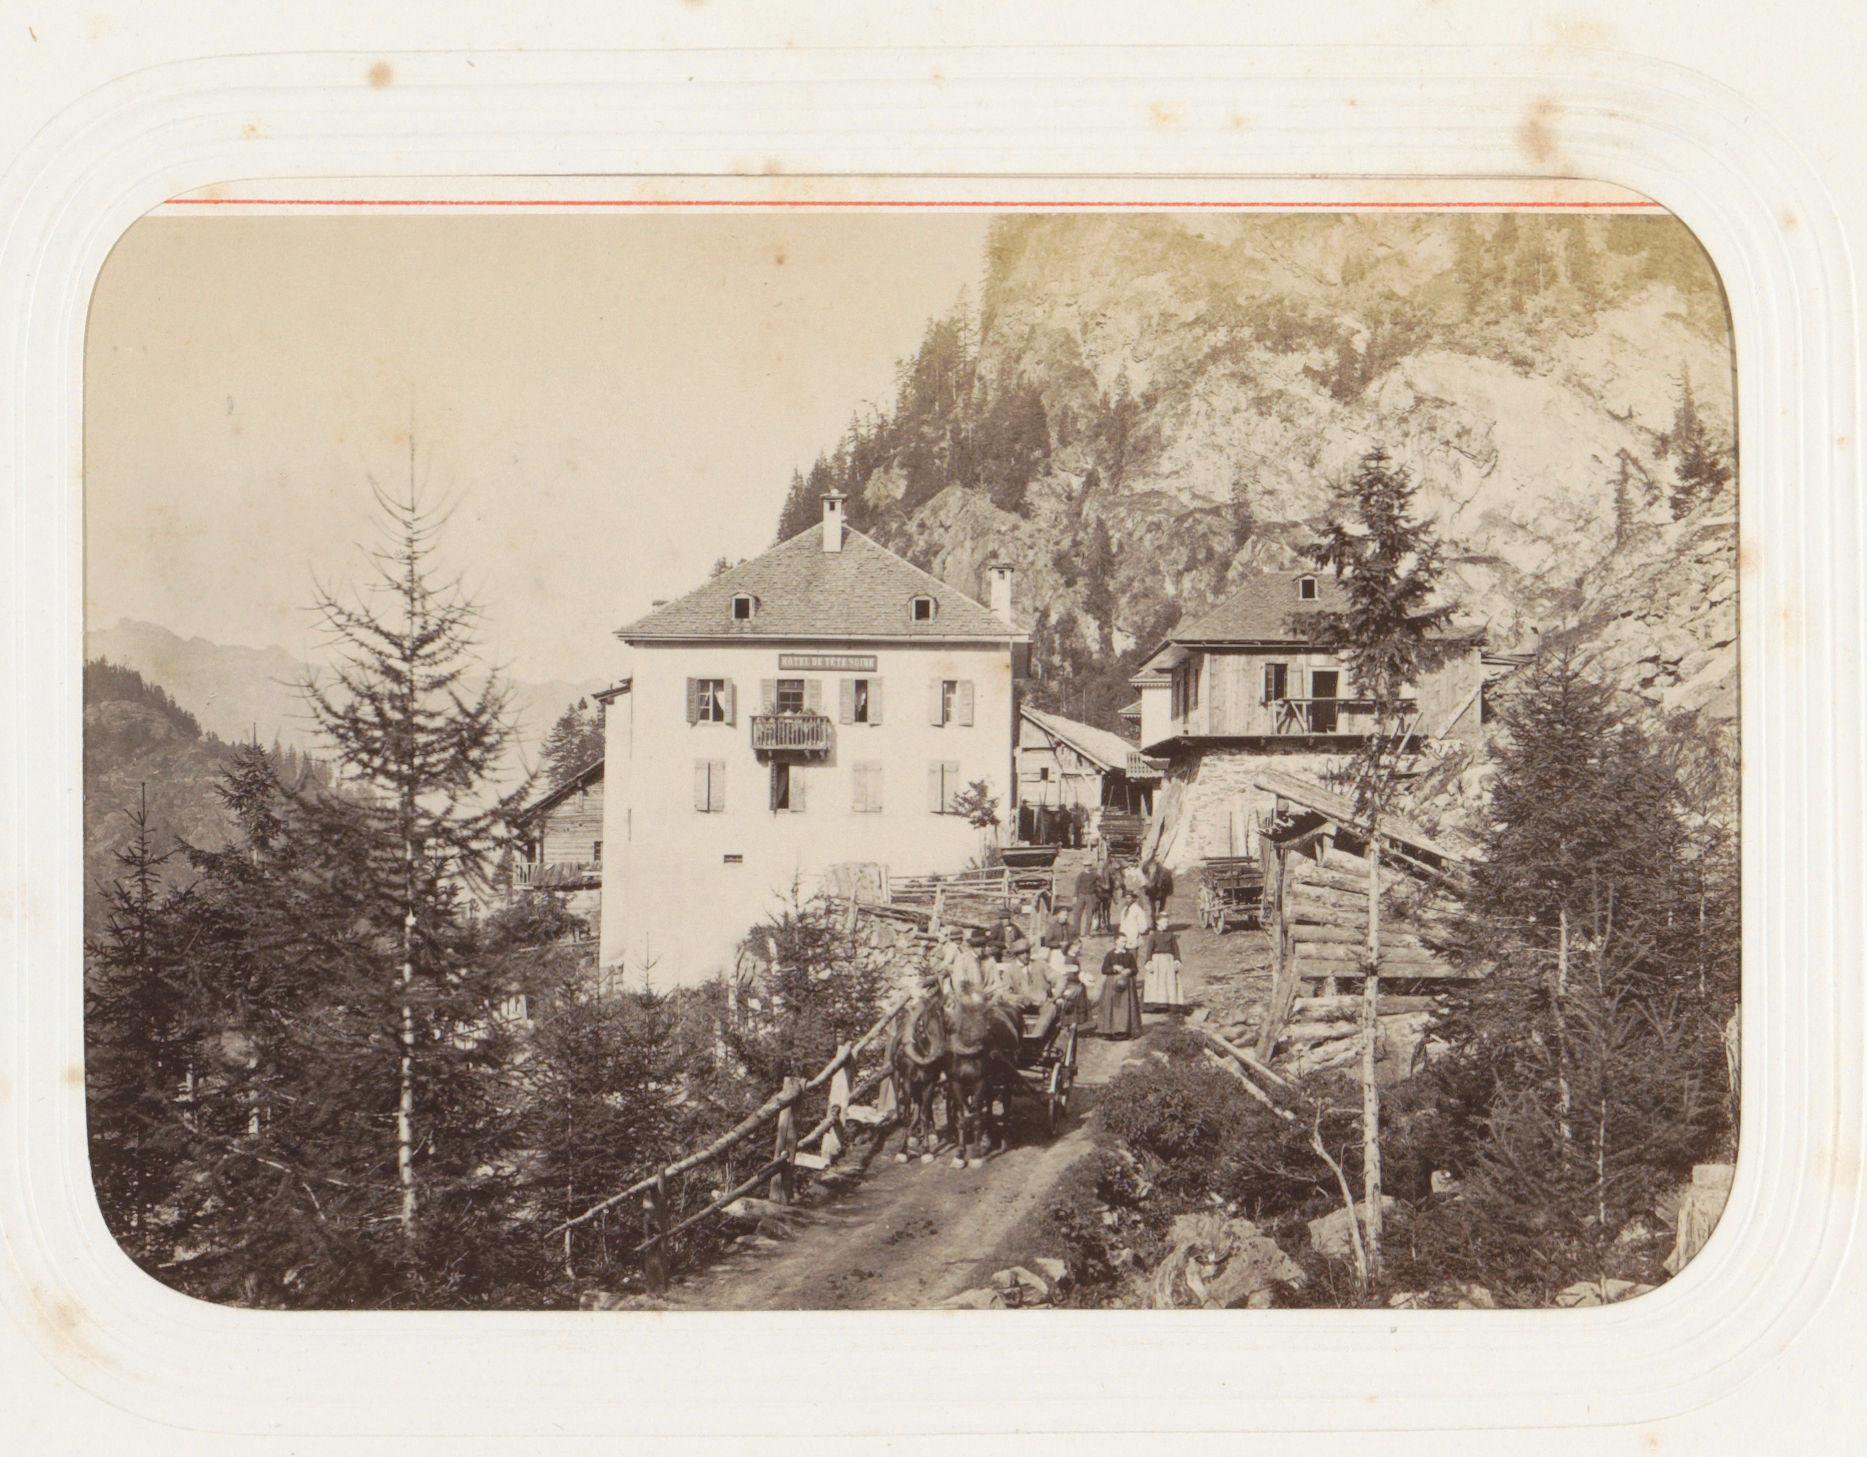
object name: cabinet photograph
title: Paardenkarren en reizigers bij Hôtel la Tête Noire op de weg naar Chamonix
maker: auguste garcin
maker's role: fotograaf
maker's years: 1816-1895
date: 1860-1880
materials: cardboard, paper, photographic support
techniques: albumen print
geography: switzerland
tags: four-wheeled, animal-drawn vehicle, e.g.: cab, carriage, coach, hotel, hostelry, inn, mountains, switzerland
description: Onderdeel van Reisalbum met bezienswaardigheden in de Zwitserse Alpen.